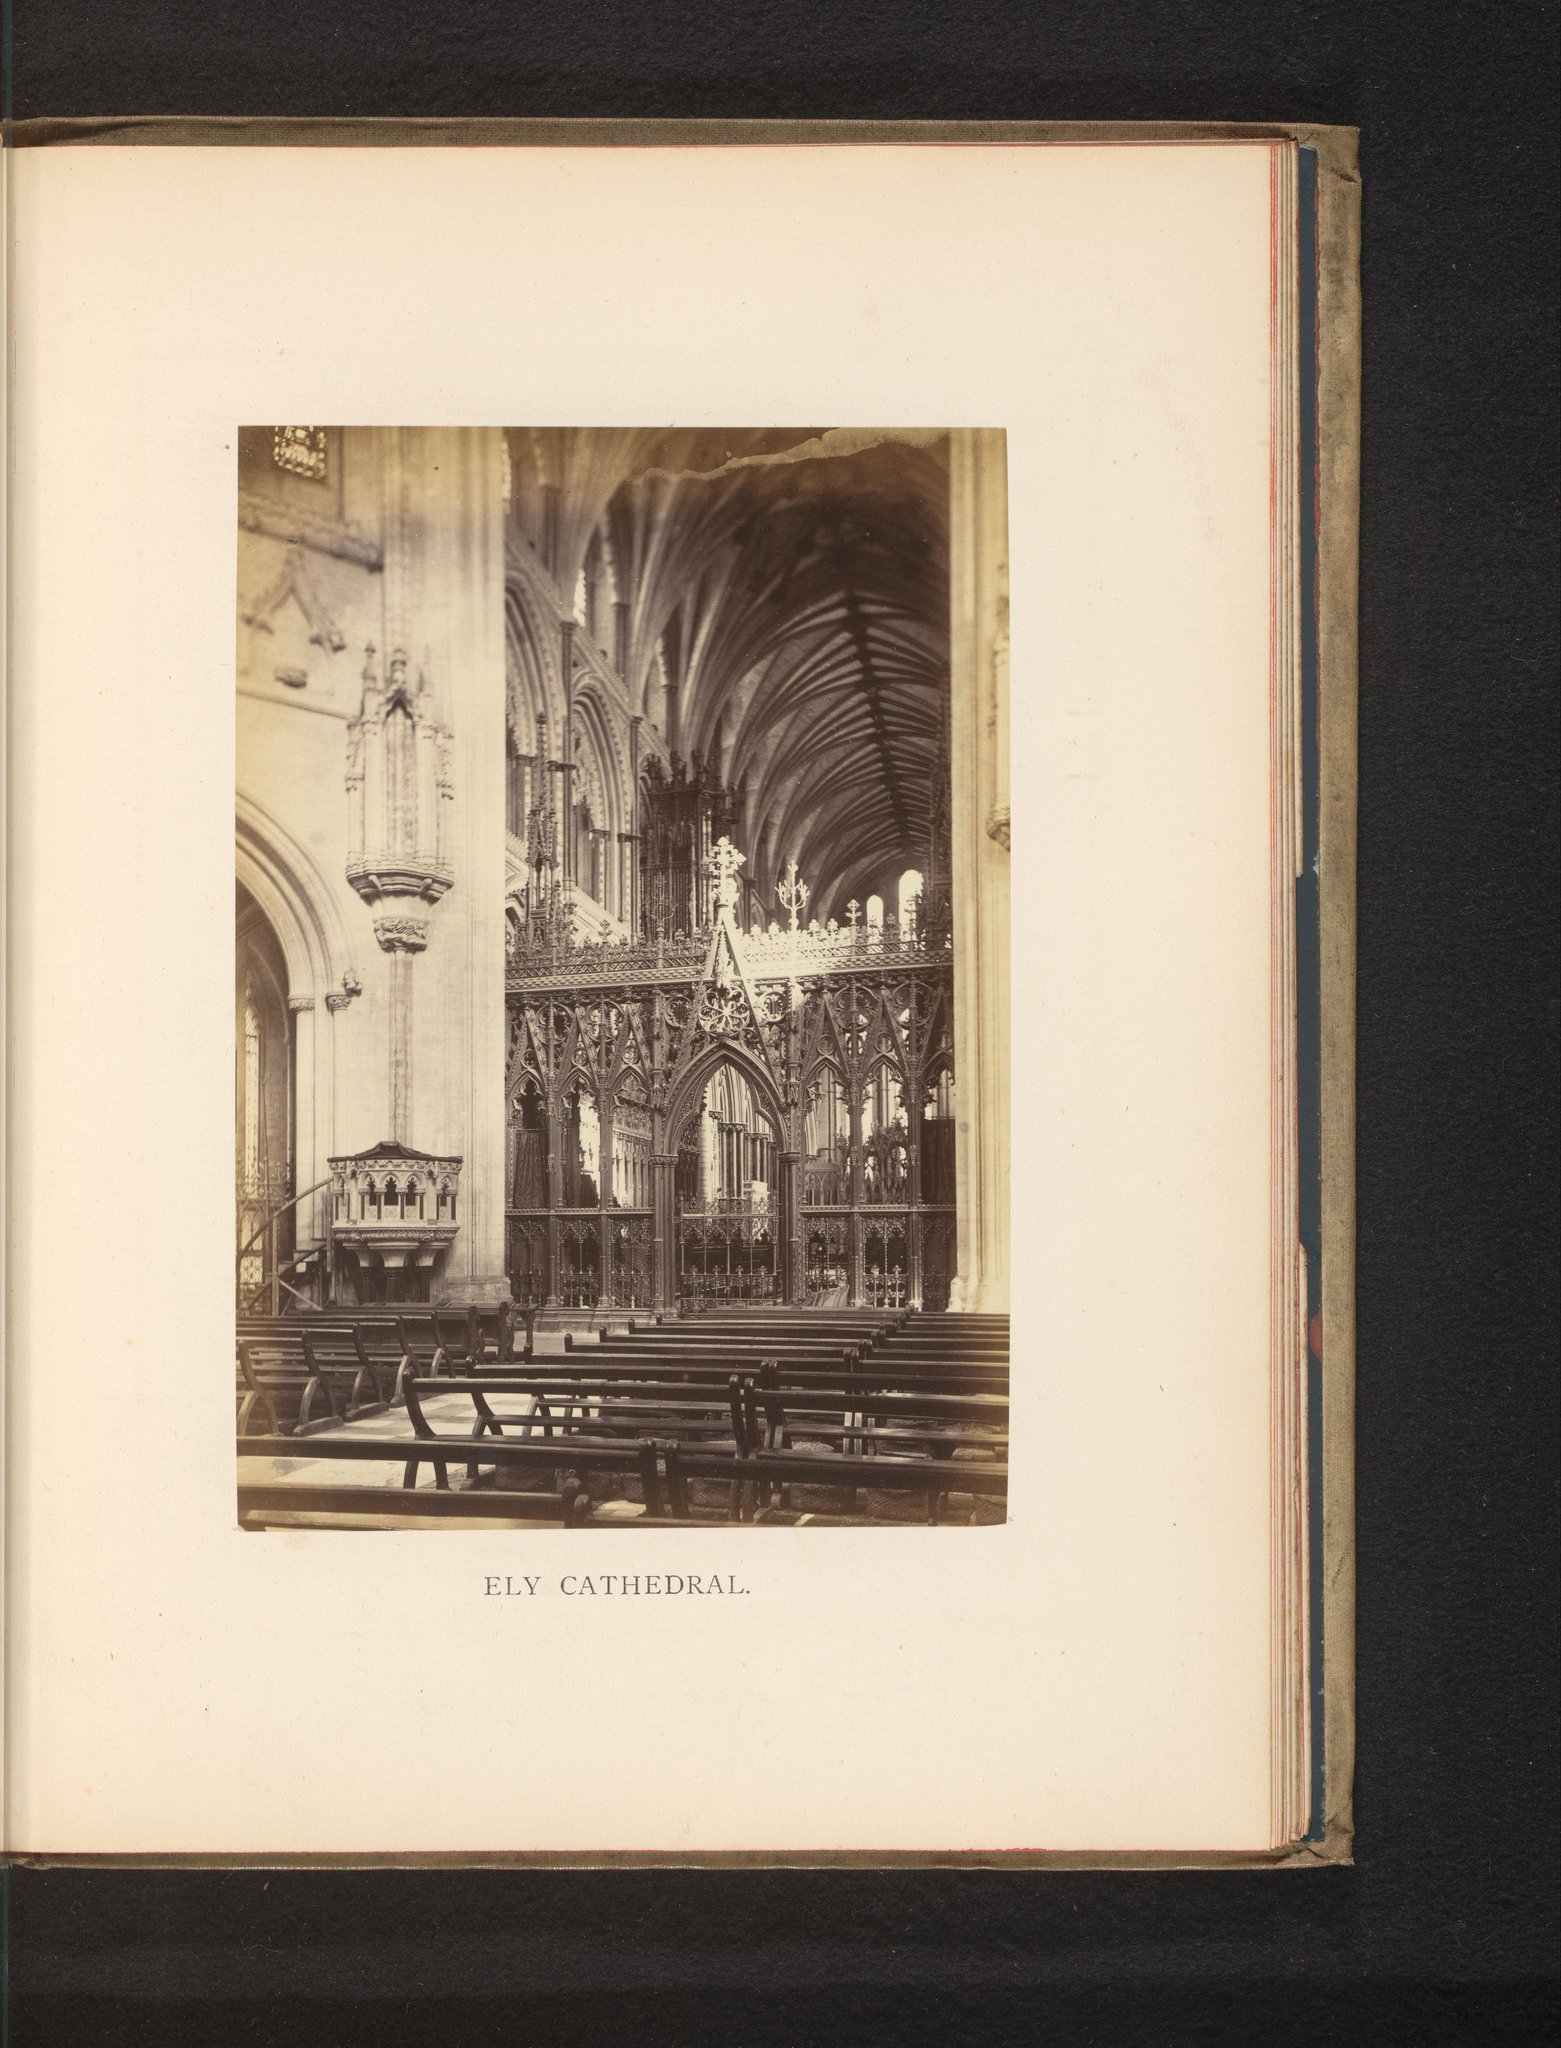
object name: photograph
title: Ely Cathedral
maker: Anonymous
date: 1858-1869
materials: photographic support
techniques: albumen print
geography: ely cathedral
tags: rood-screen, choir-screen; iconostasis, parts of church interior: aisle, interior of church